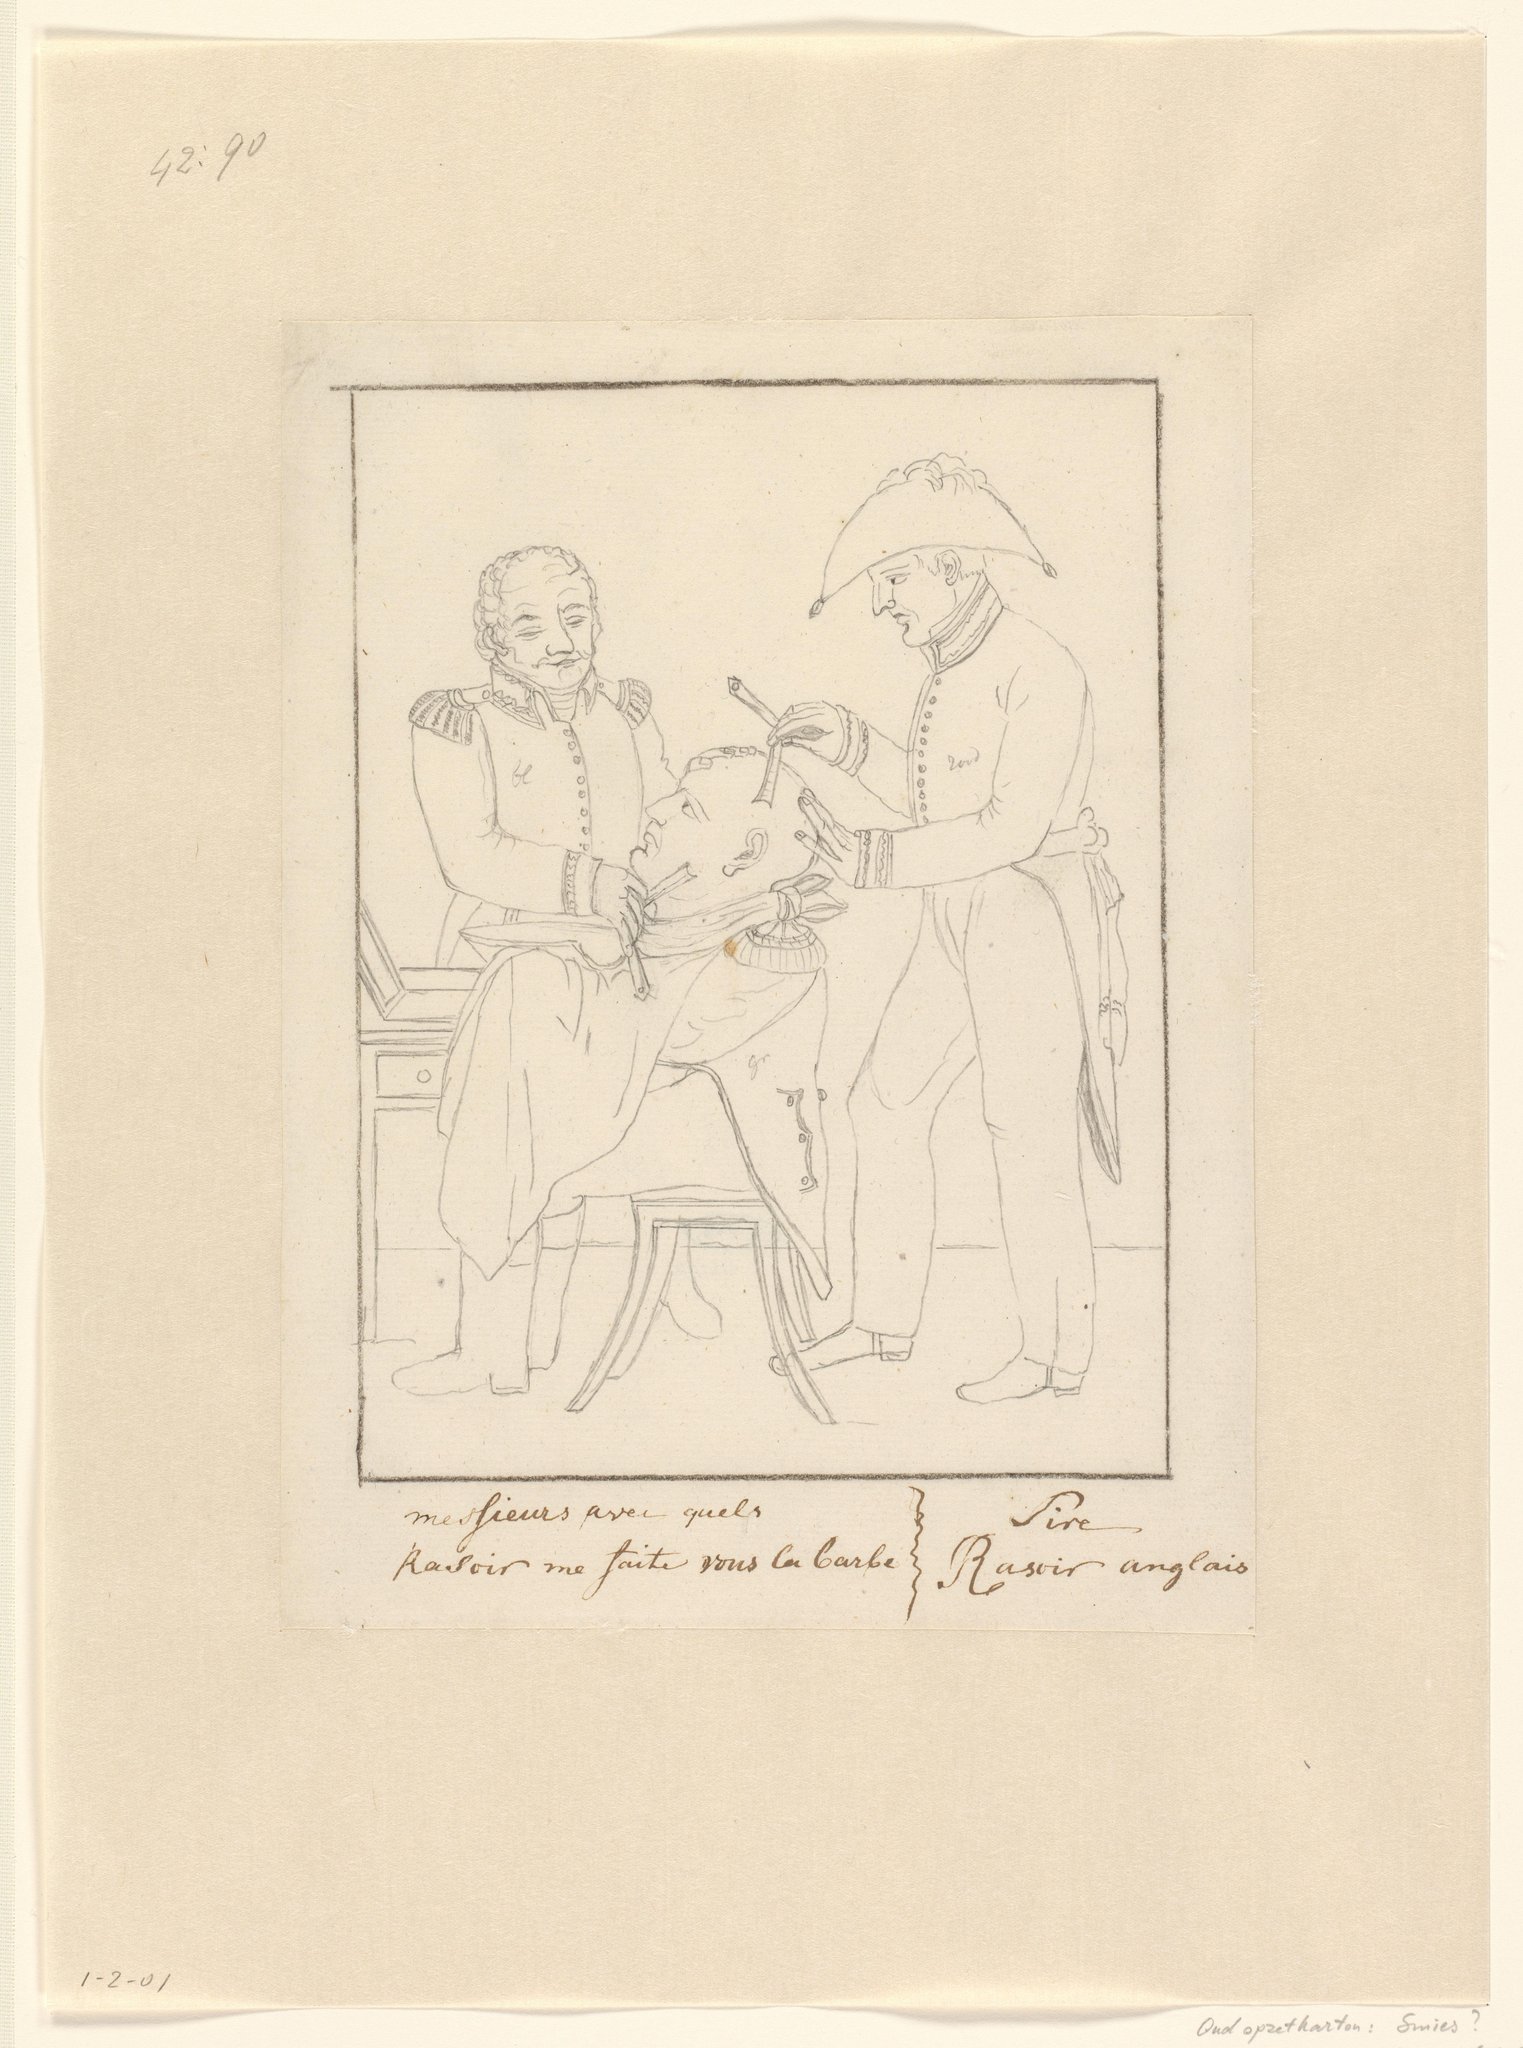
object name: drawing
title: Spotprent op Napoleon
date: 1800-1900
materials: chalk, paper, pencil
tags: napoleon i (emperor of the french), historical persons, barber, barbershop, political caricatures and satires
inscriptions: inscription: ‘messieurs avec quels Rasoir me faite vous la barbe. Sire Rasoir anglais.’